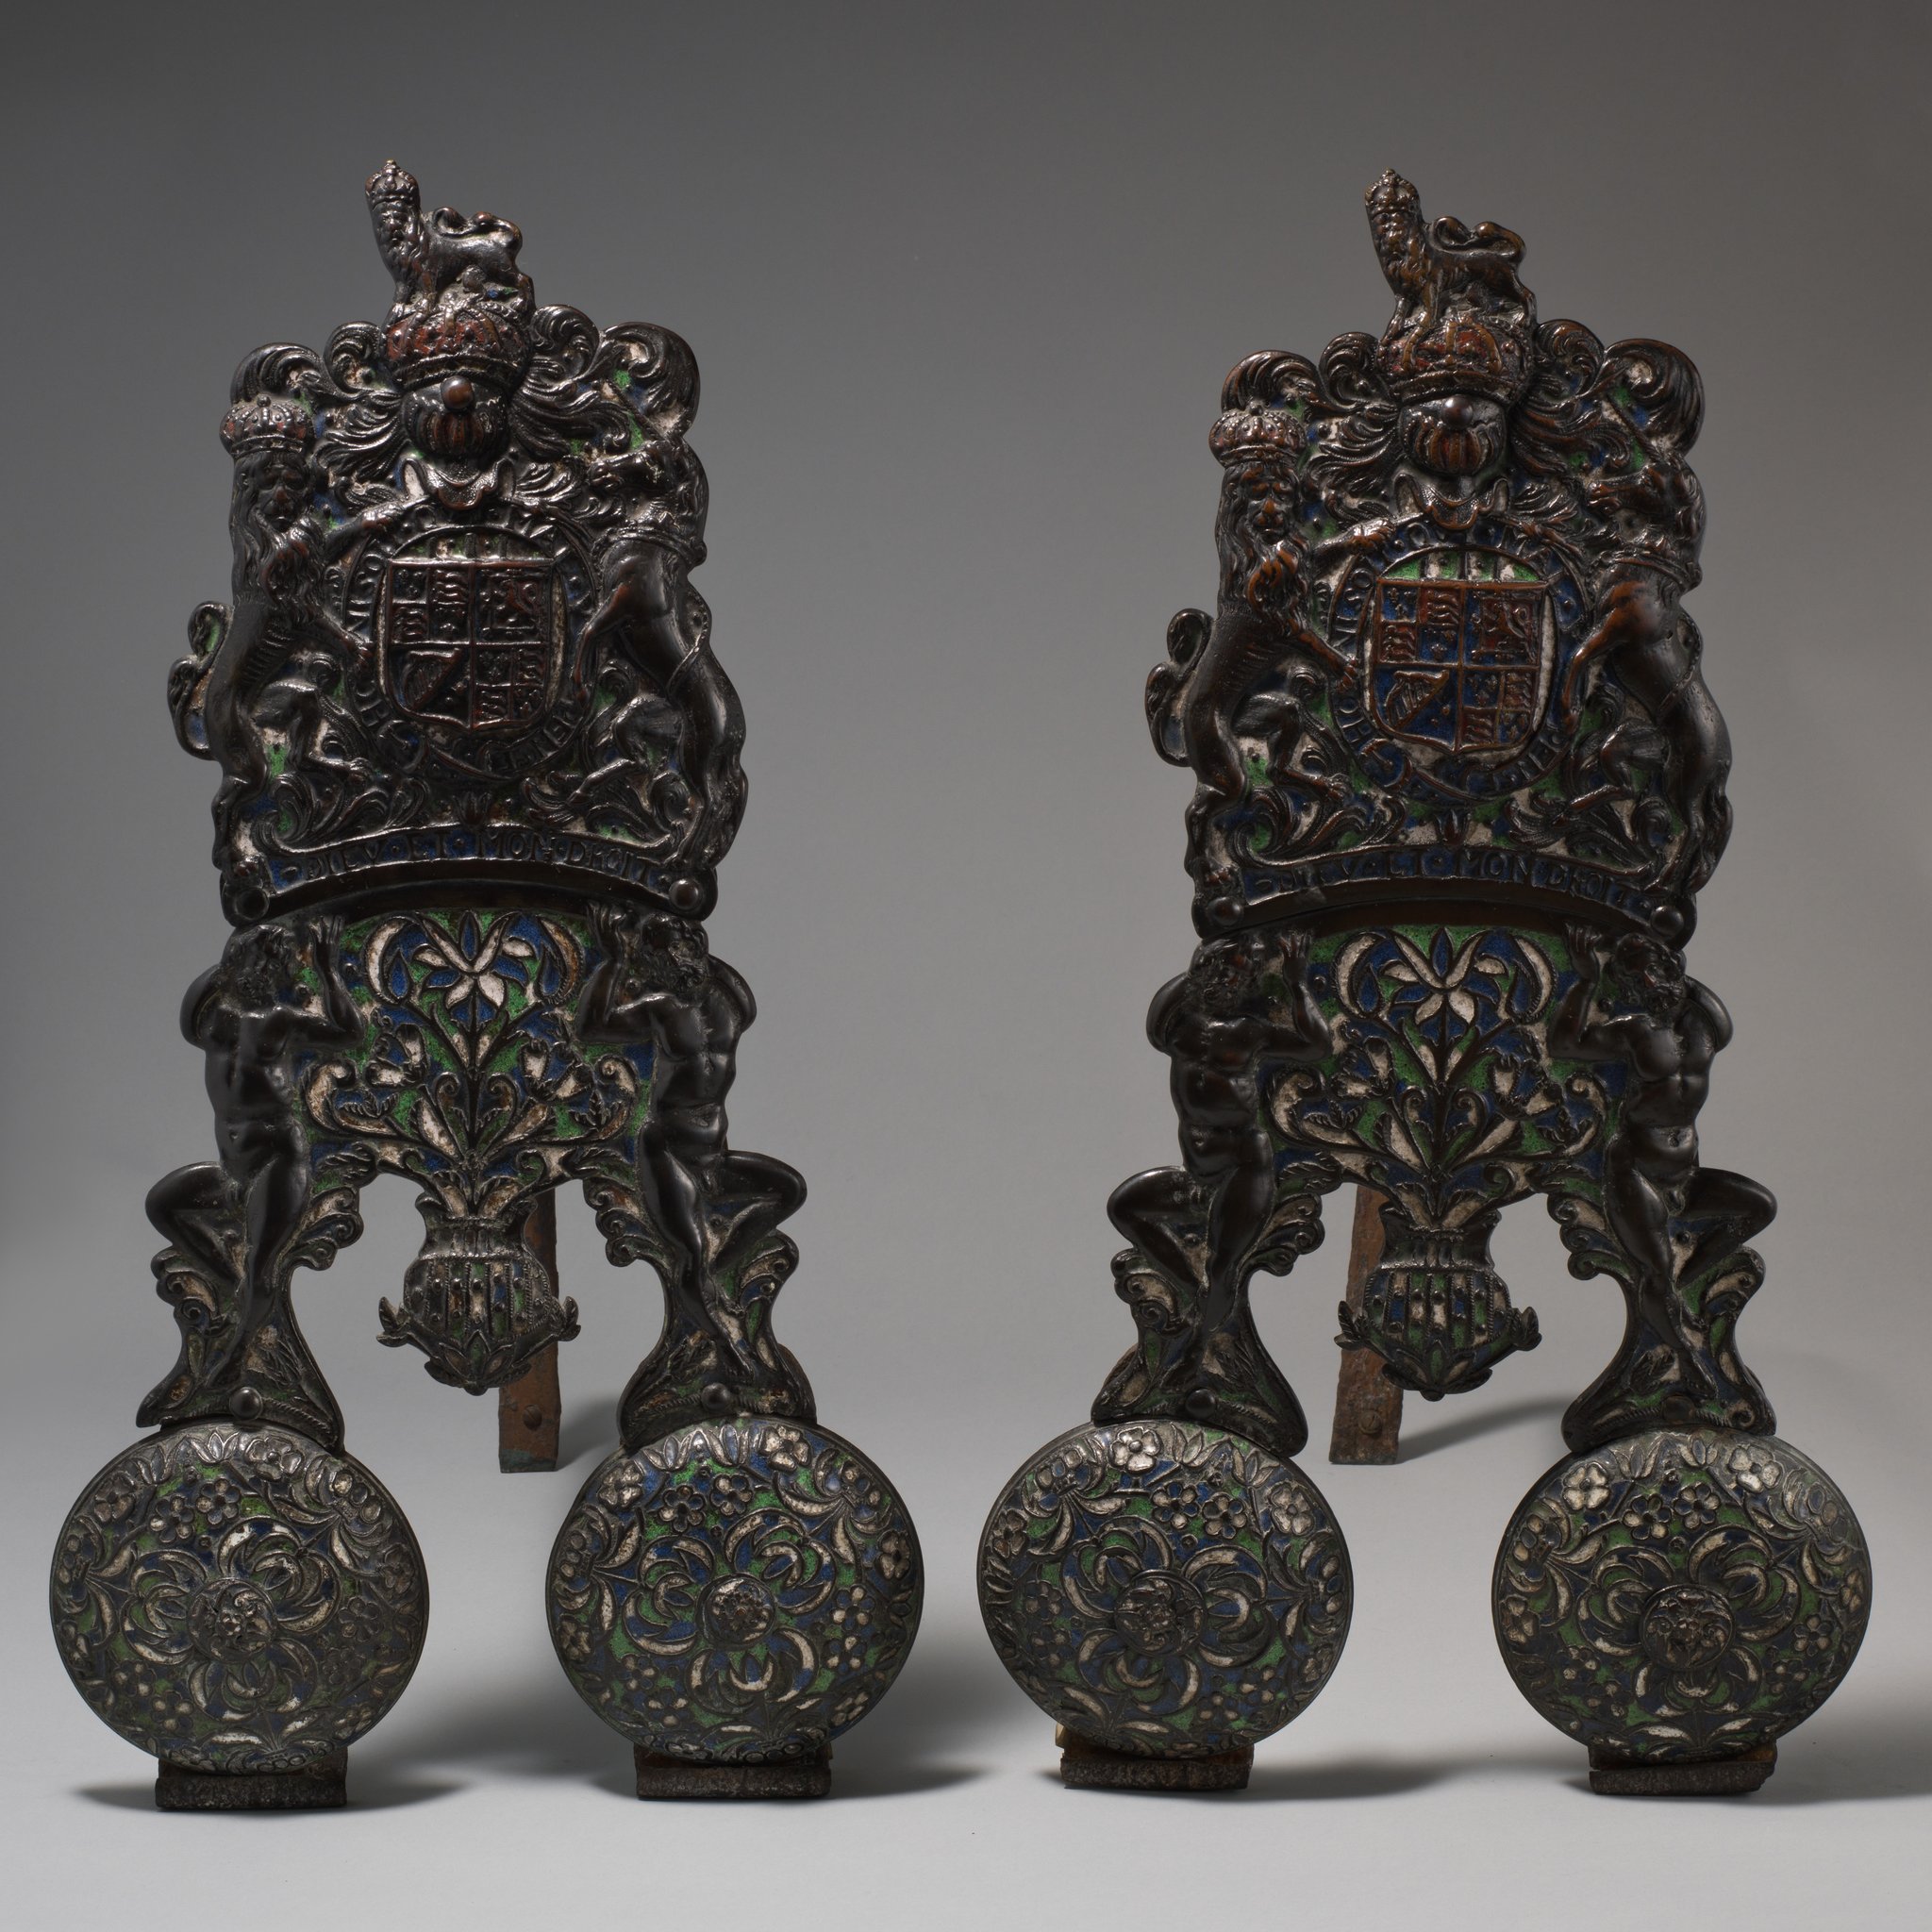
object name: andiron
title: Pair of andirons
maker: stephen pilcherd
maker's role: maker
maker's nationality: british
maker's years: 1570-1670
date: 1660-1680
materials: brass, iron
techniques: enamel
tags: male nudes,horses,coat of arms